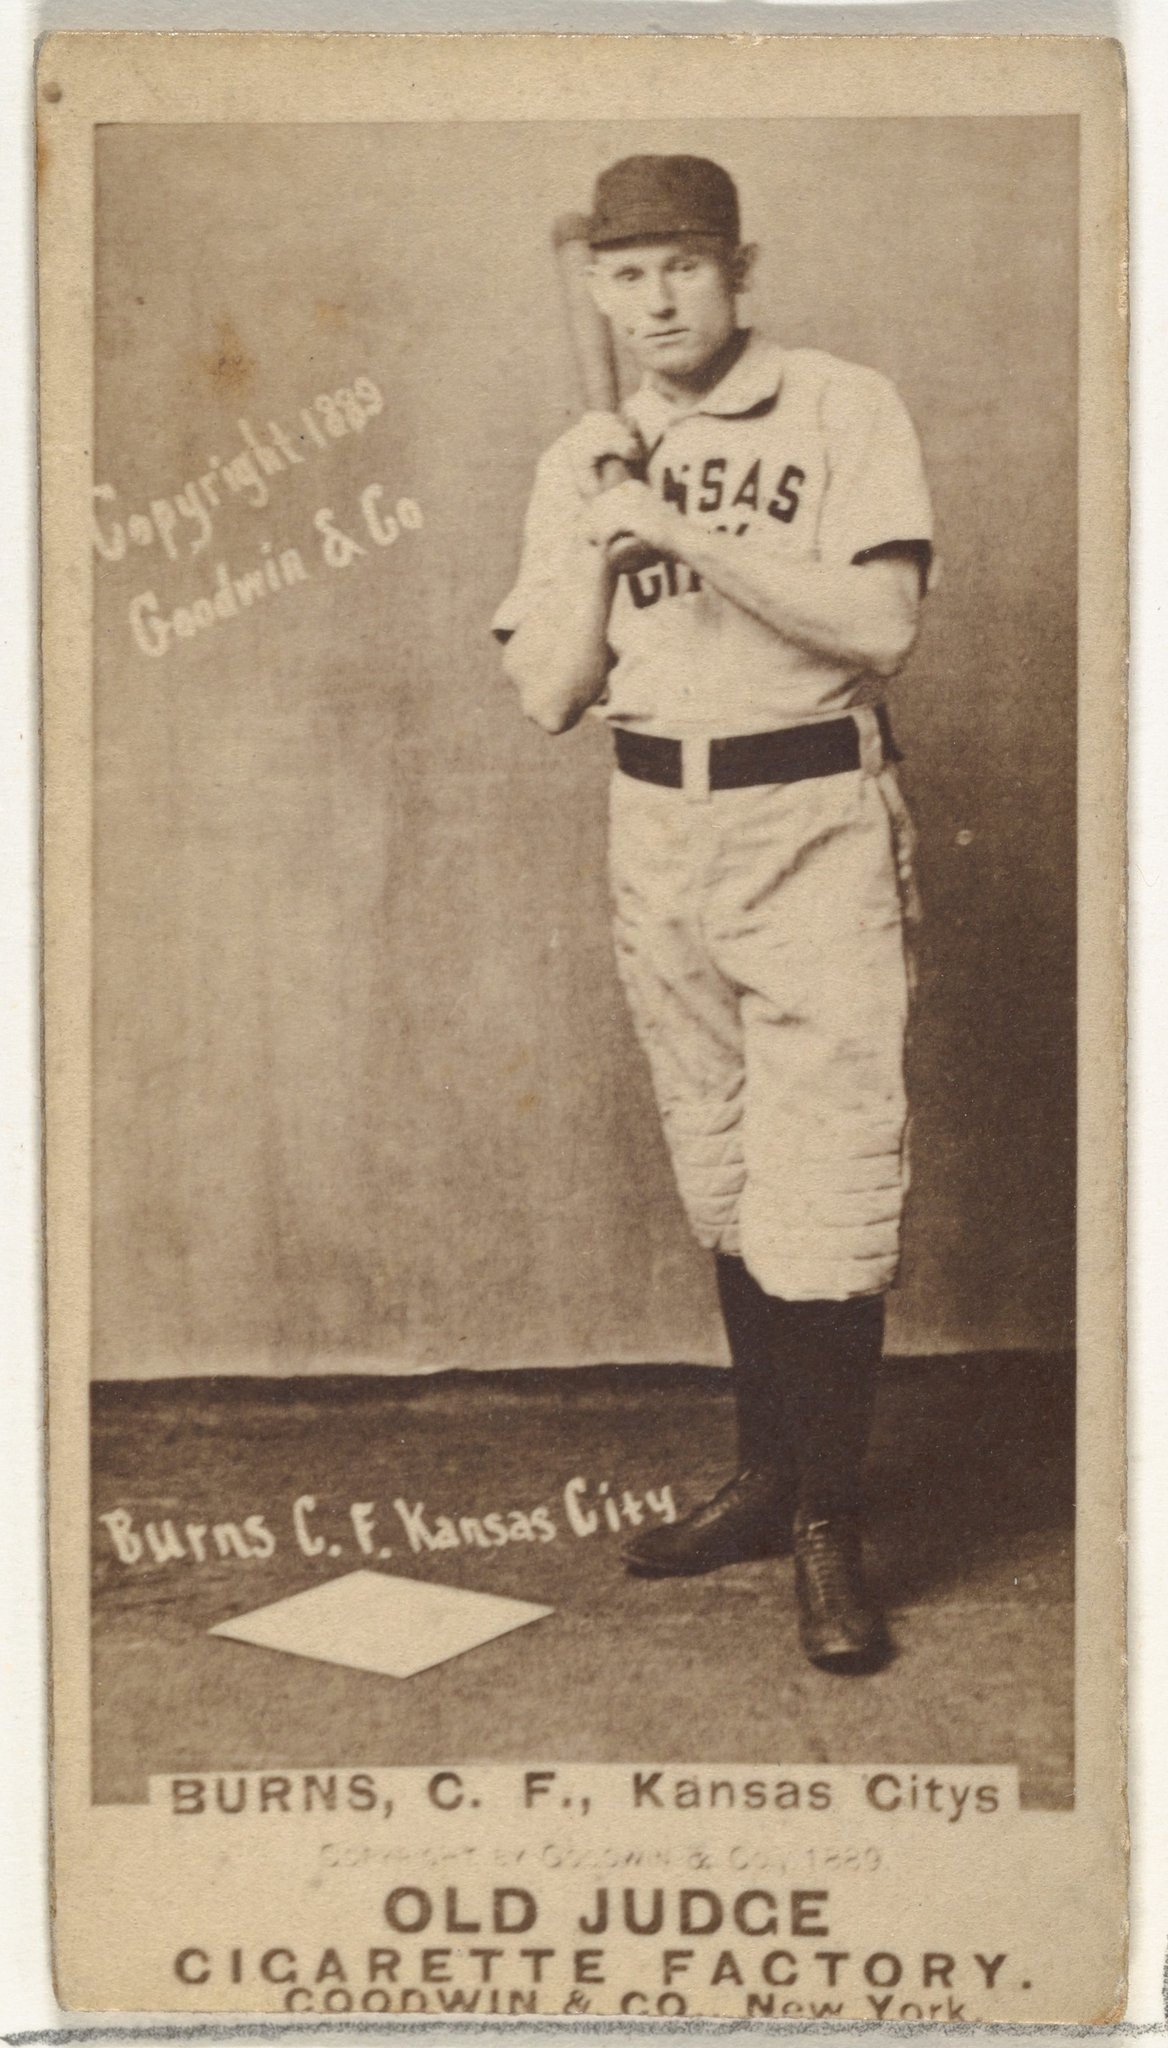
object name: baseball card, photograph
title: James M. "Jim" Burns, Center Field, Kansas City Cowboys, from the Old Judge series (N172) for Old Judge Cigarettes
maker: goodwin & company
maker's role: publisher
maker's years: 1850-1950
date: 1889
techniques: albumen silver print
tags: men,portraits,baseball,athletes